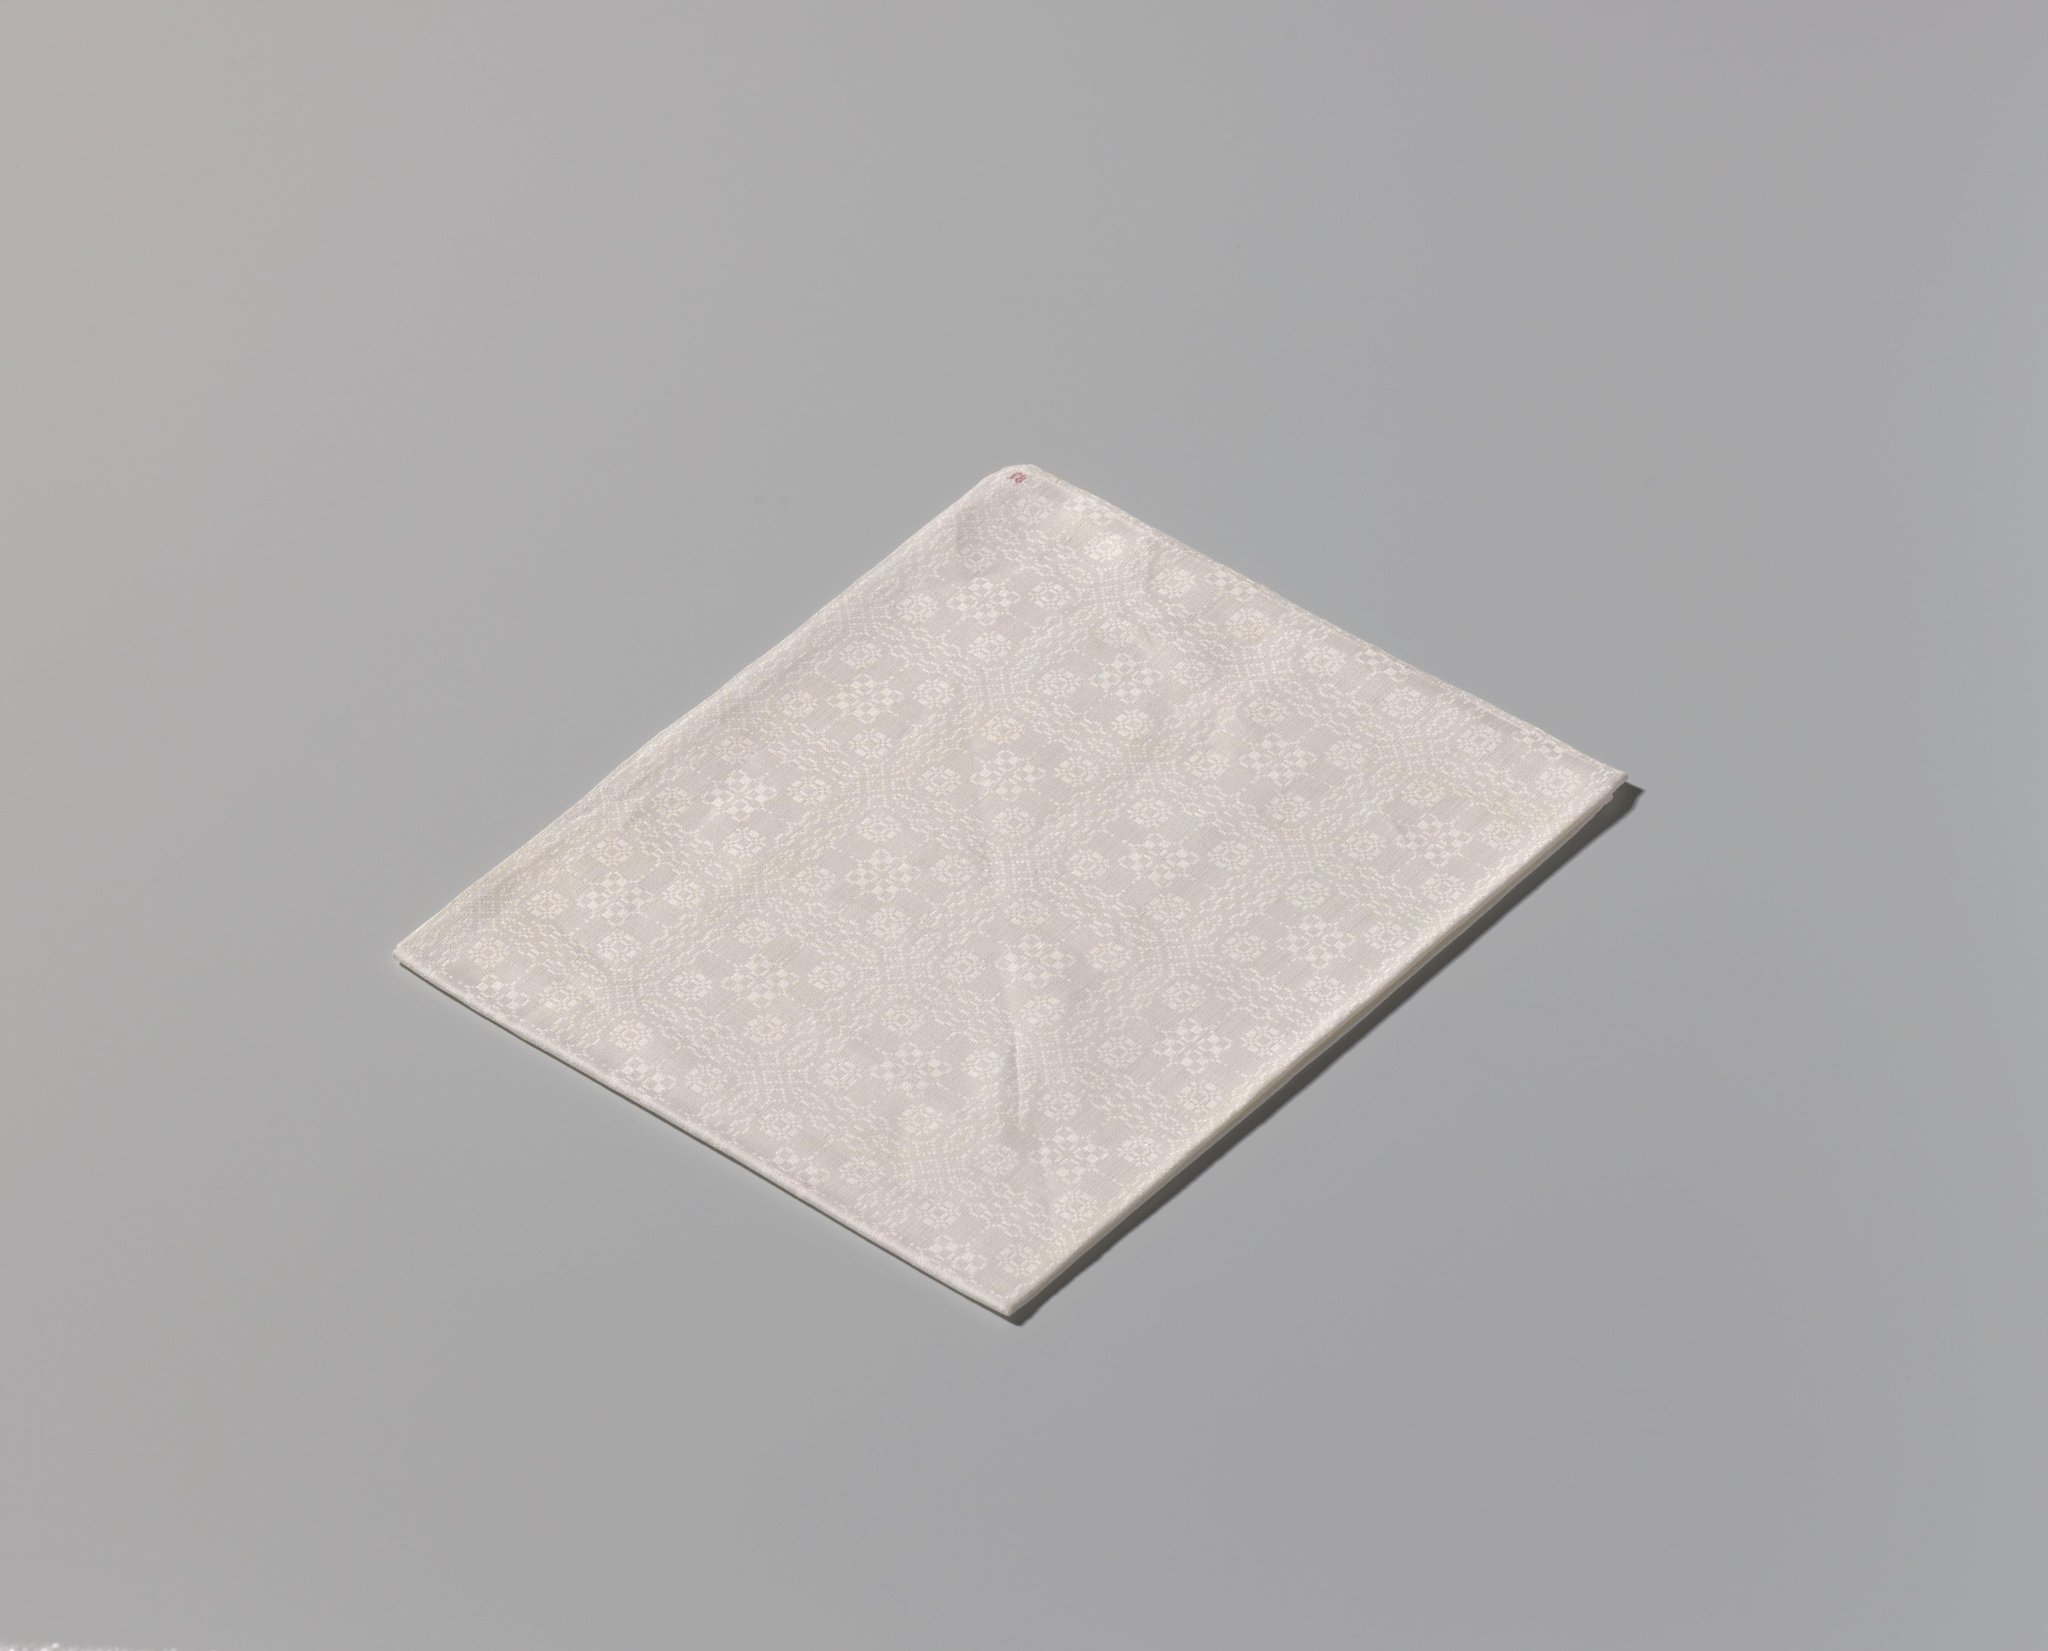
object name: napkin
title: Servet van pellendamast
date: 1675-1725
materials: linen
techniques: weave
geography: north brabant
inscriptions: mark: ‘18’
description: Servet van pellendamast. Elkaar snijdende rijen van ruiten vormen vierkanten, waarbinnen vijf blokken. Het servet is gehalveerd. Het servet hoort bij twaalf servetten en een tafellaken.